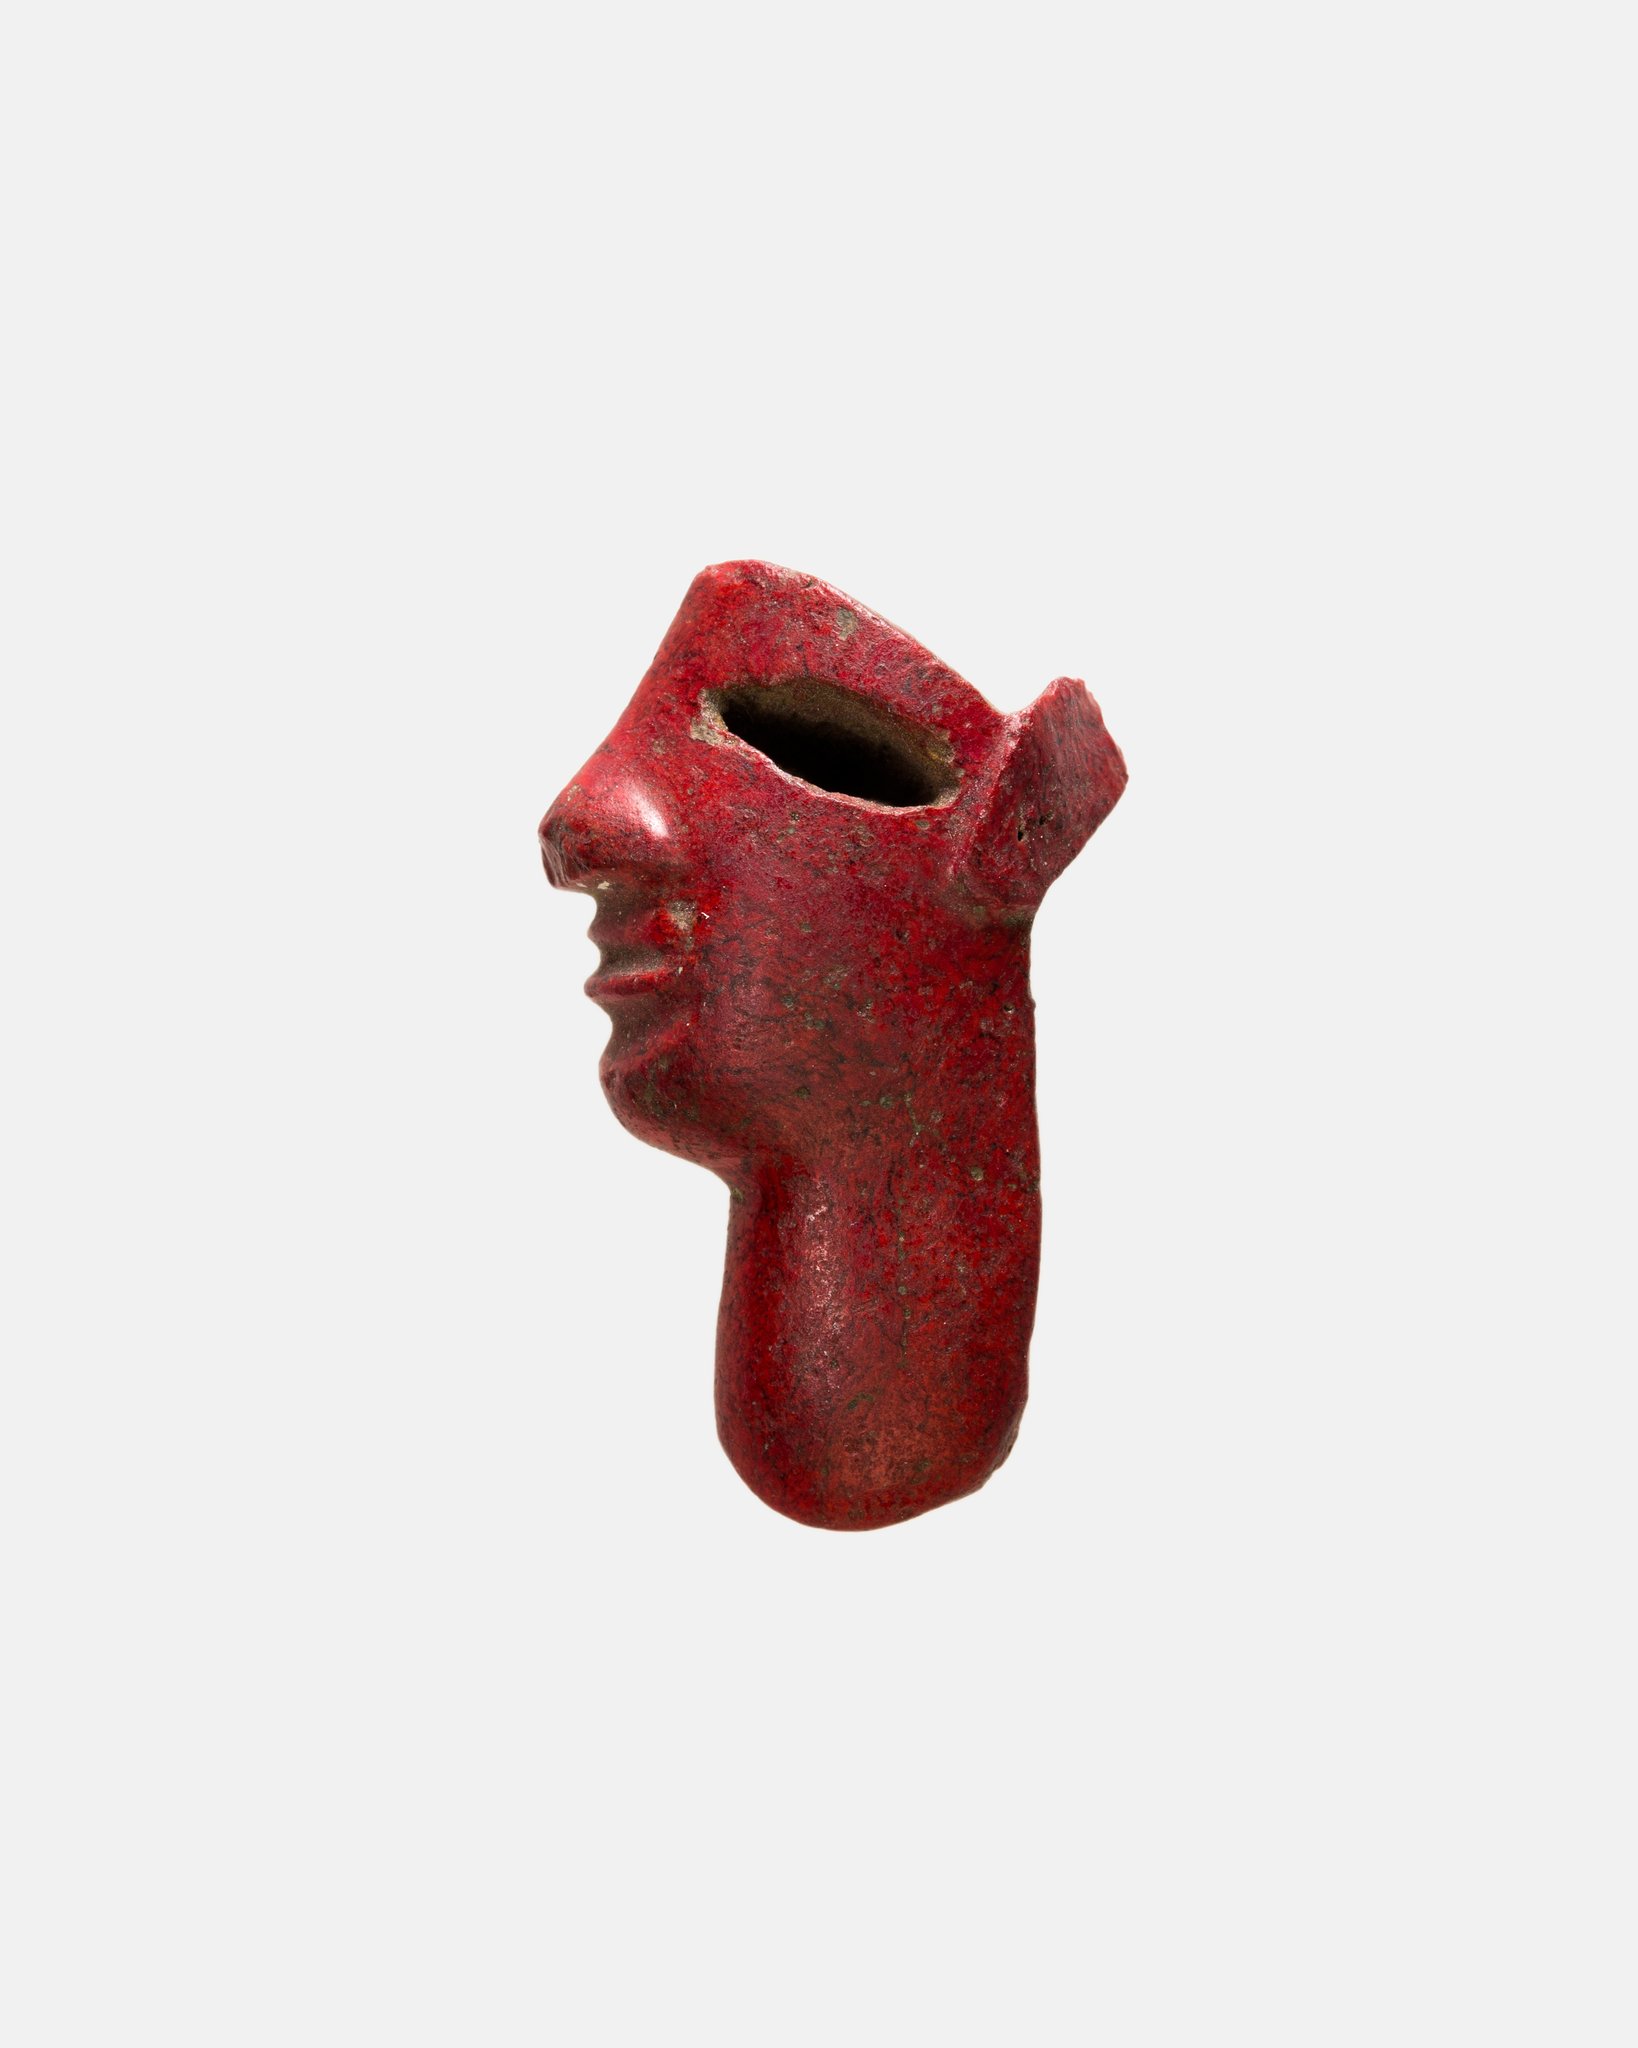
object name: inlay, profile head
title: Profile face inlay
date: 570-530 BCE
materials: glass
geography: egypt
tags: faces